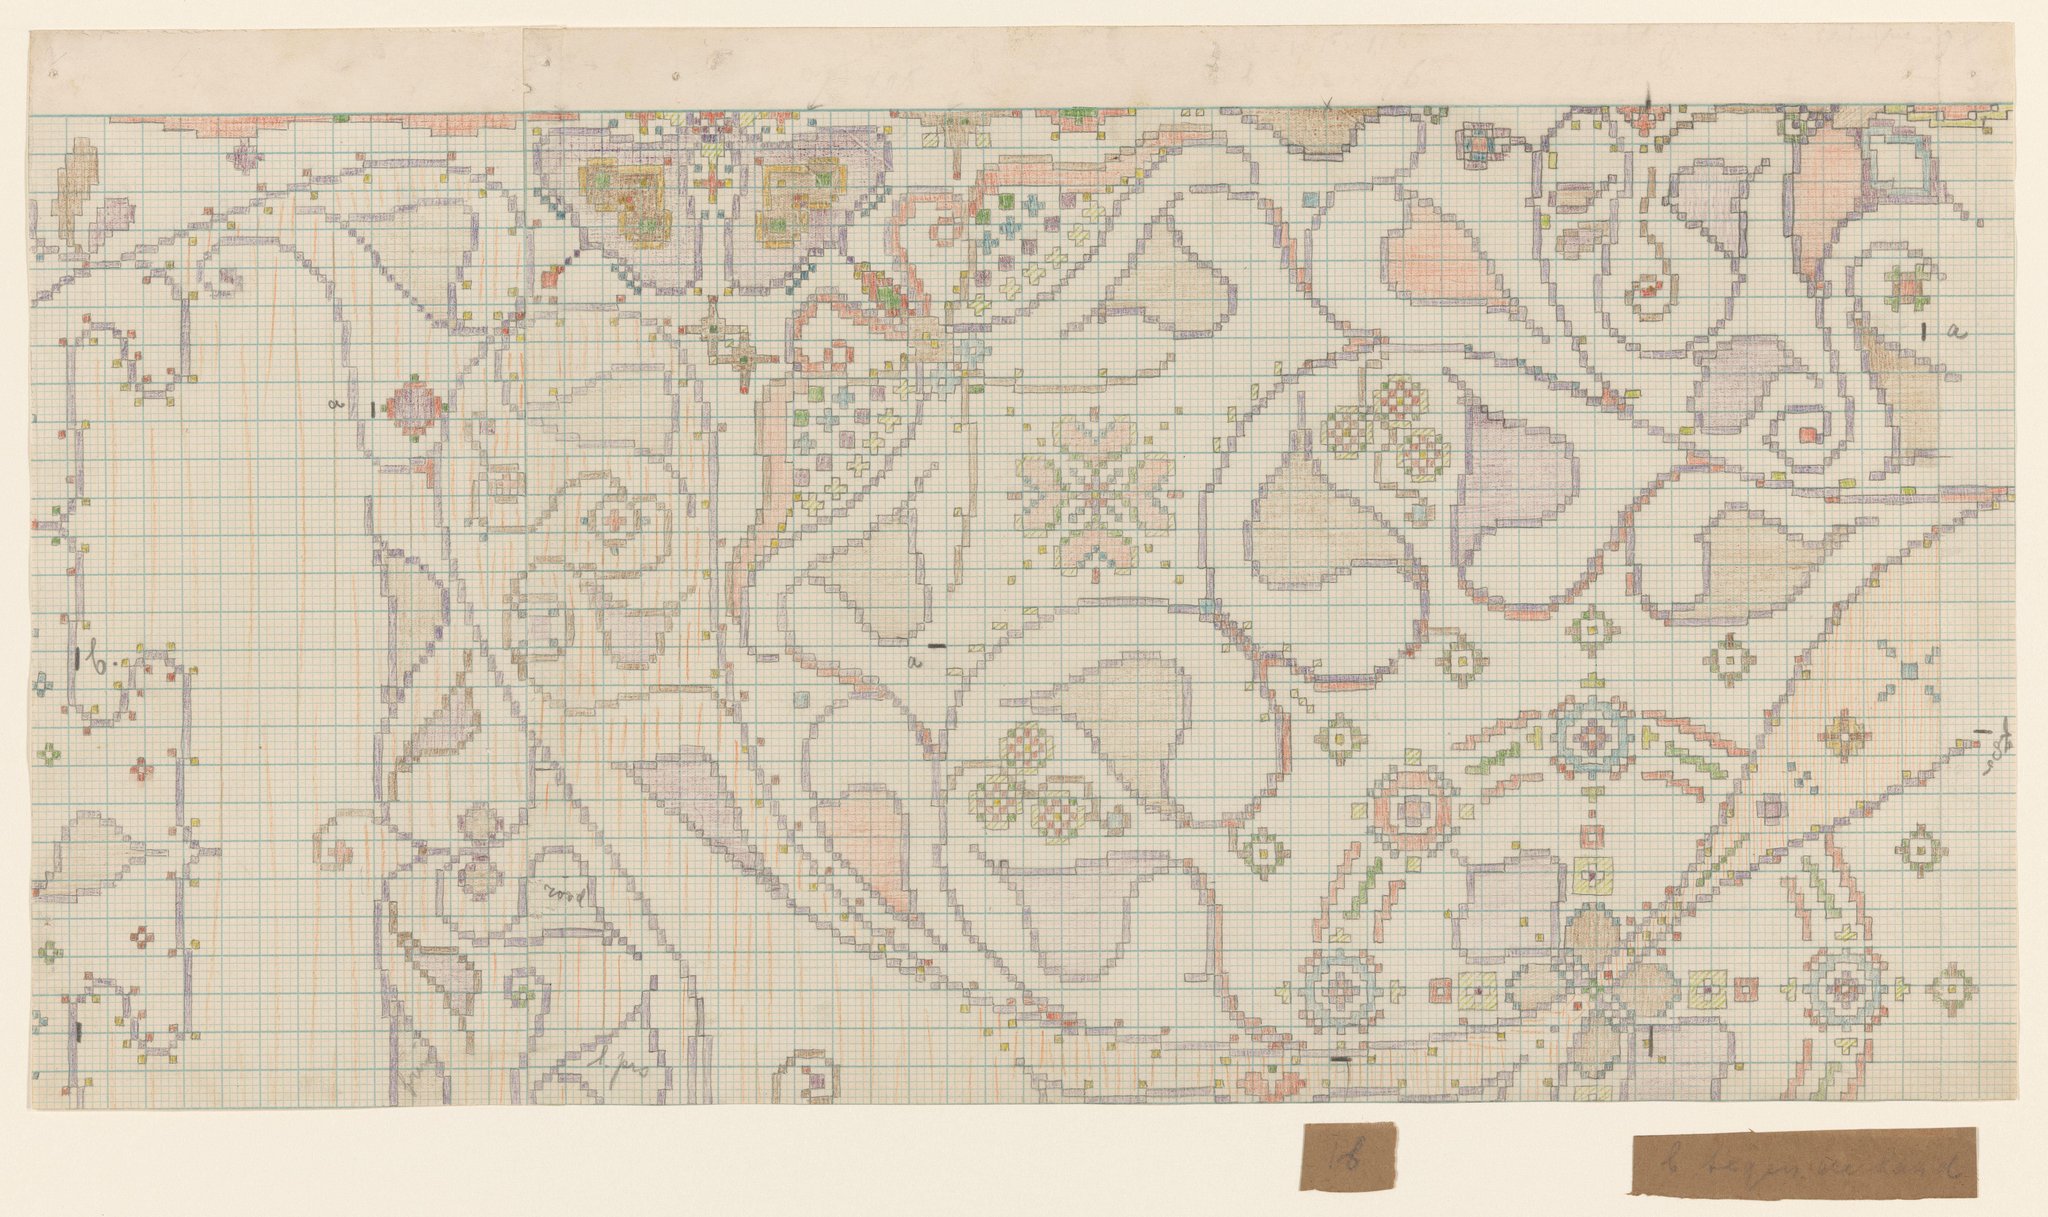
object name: design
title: Ontwerp voor een tapijt in Het Uiltje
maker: theo nieuwenhuis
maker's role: designer, draughtsman, print maker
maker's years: 1866-1951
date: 1876-1951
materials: pencil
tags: foliage ~ ornament